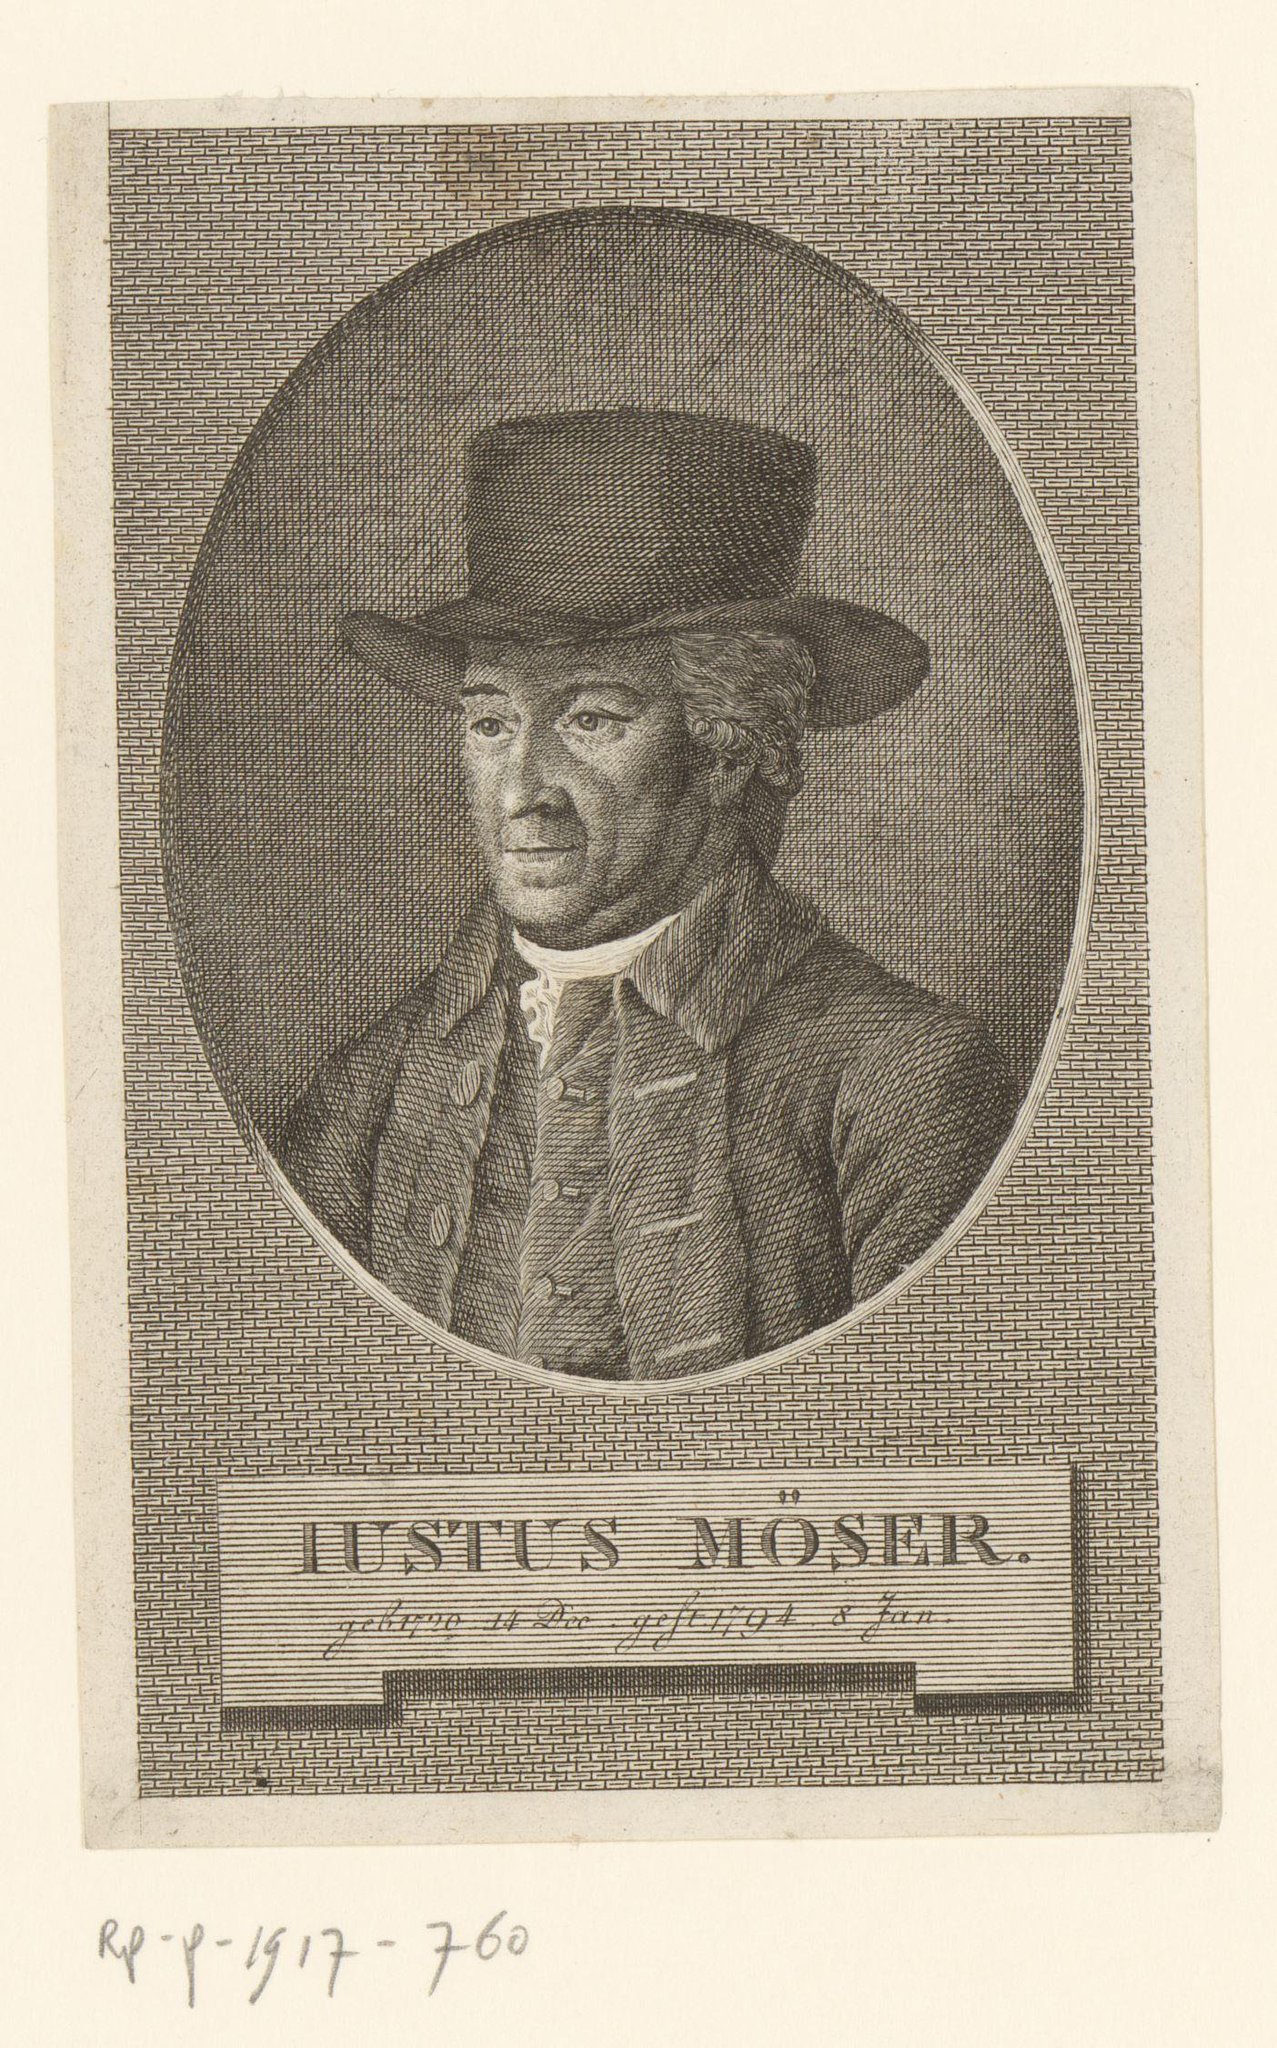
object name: print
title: Portret van Justus Möser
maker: johann samuel ringk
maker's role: print maker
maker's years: -1814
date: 1794-1814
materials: paper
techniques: engraving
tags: historical persons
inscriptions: collector's mark: Lugt 2228